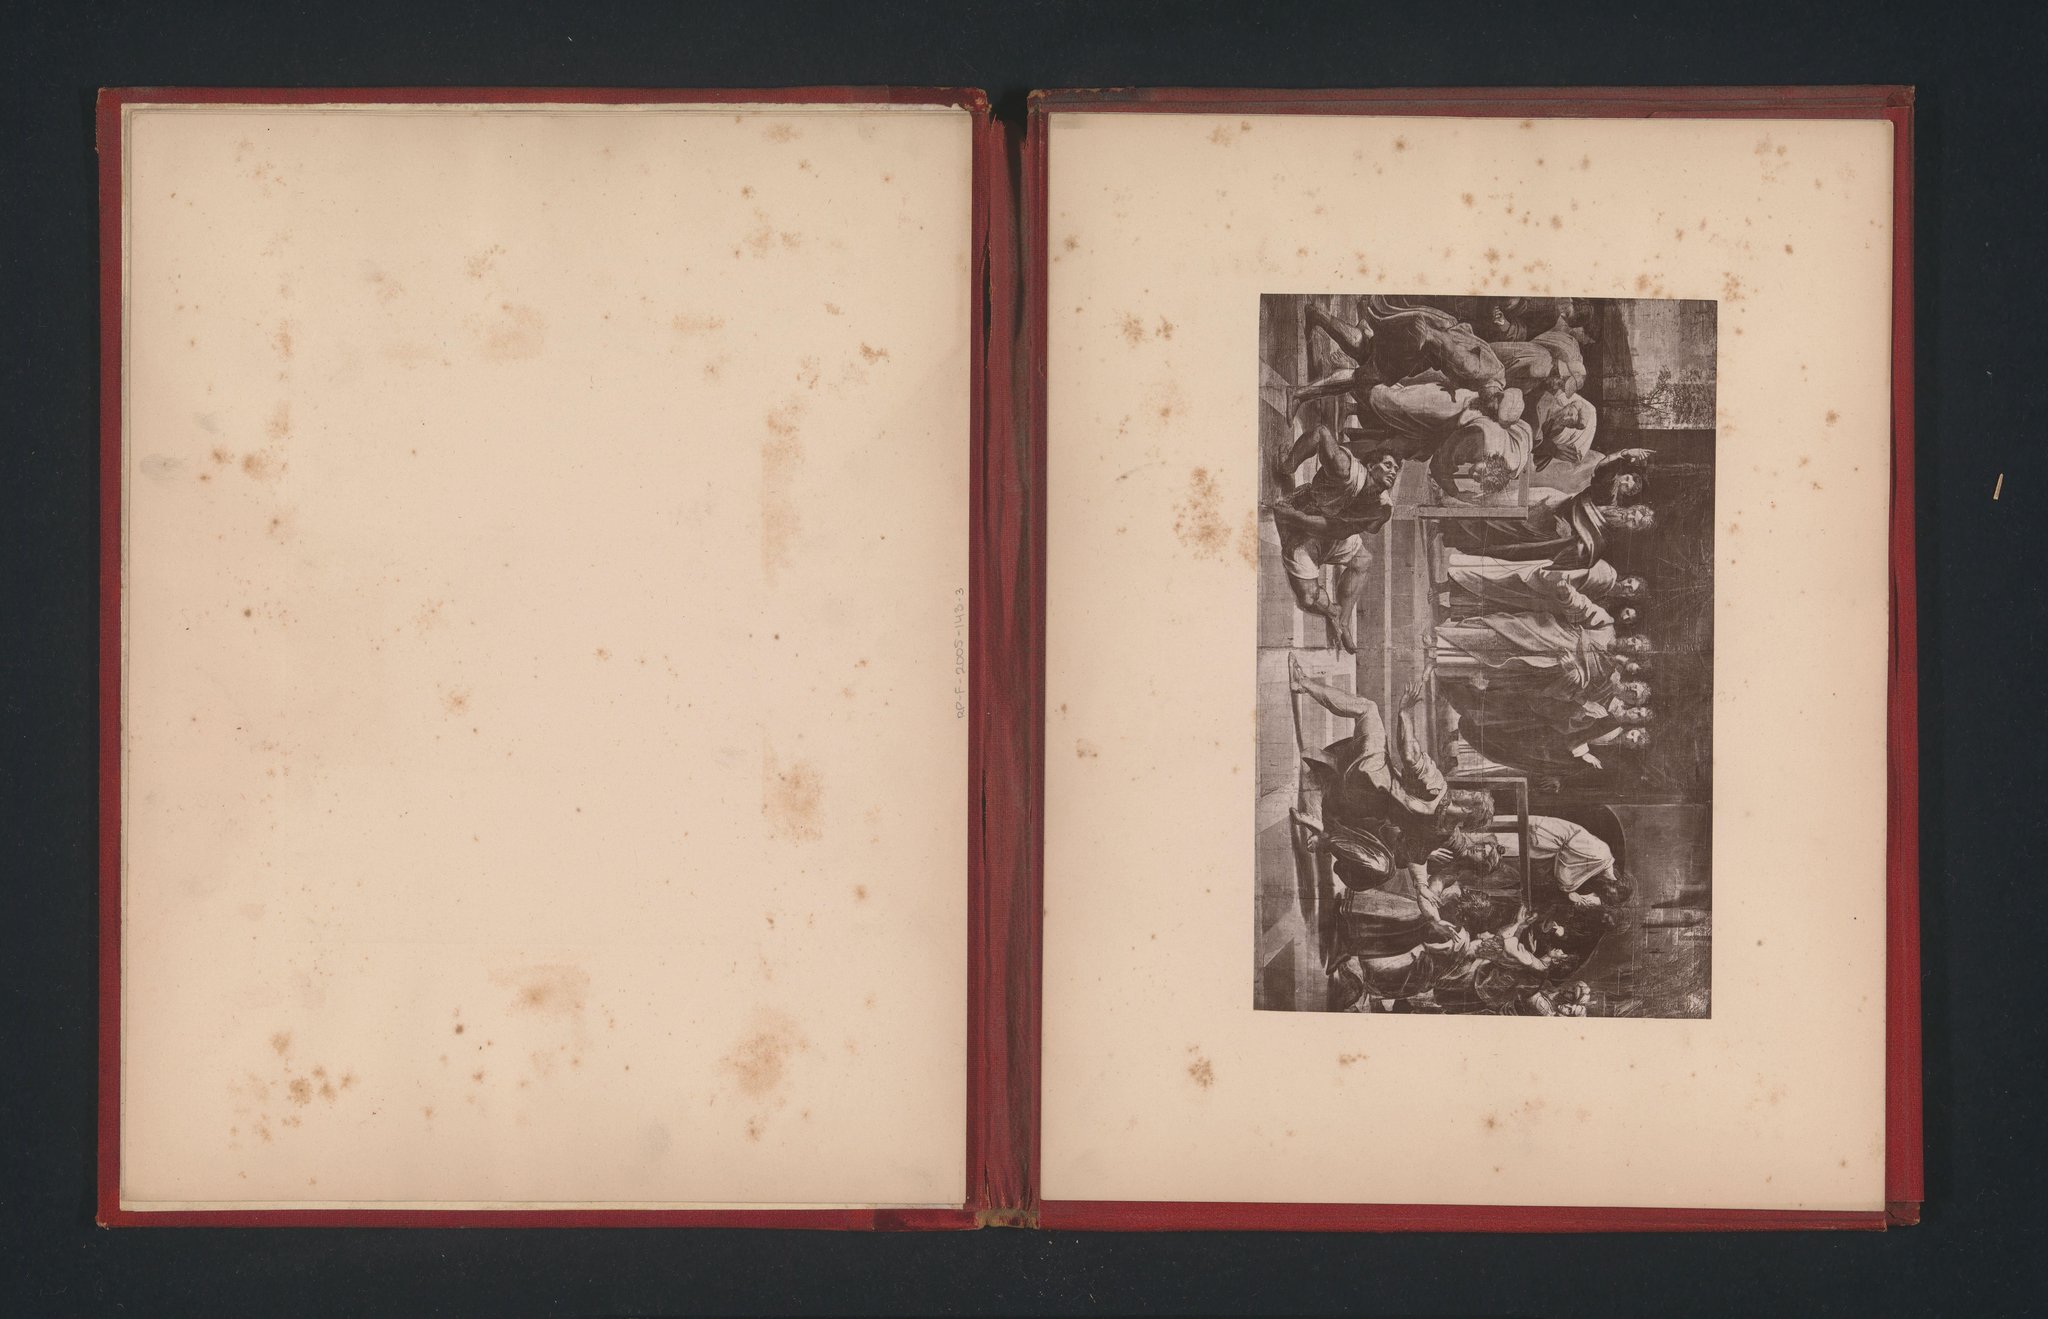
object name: reproduction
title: Death of Ananias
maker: charles thurston thompson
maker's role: fotograaf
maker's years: 1816-1868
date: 1880-1885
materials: paper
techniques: woodburytype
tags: ananias, rebuked by peter, falls down and dies between his gifts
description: Deze prent maakt deel uit van omslag met 9 bladen.